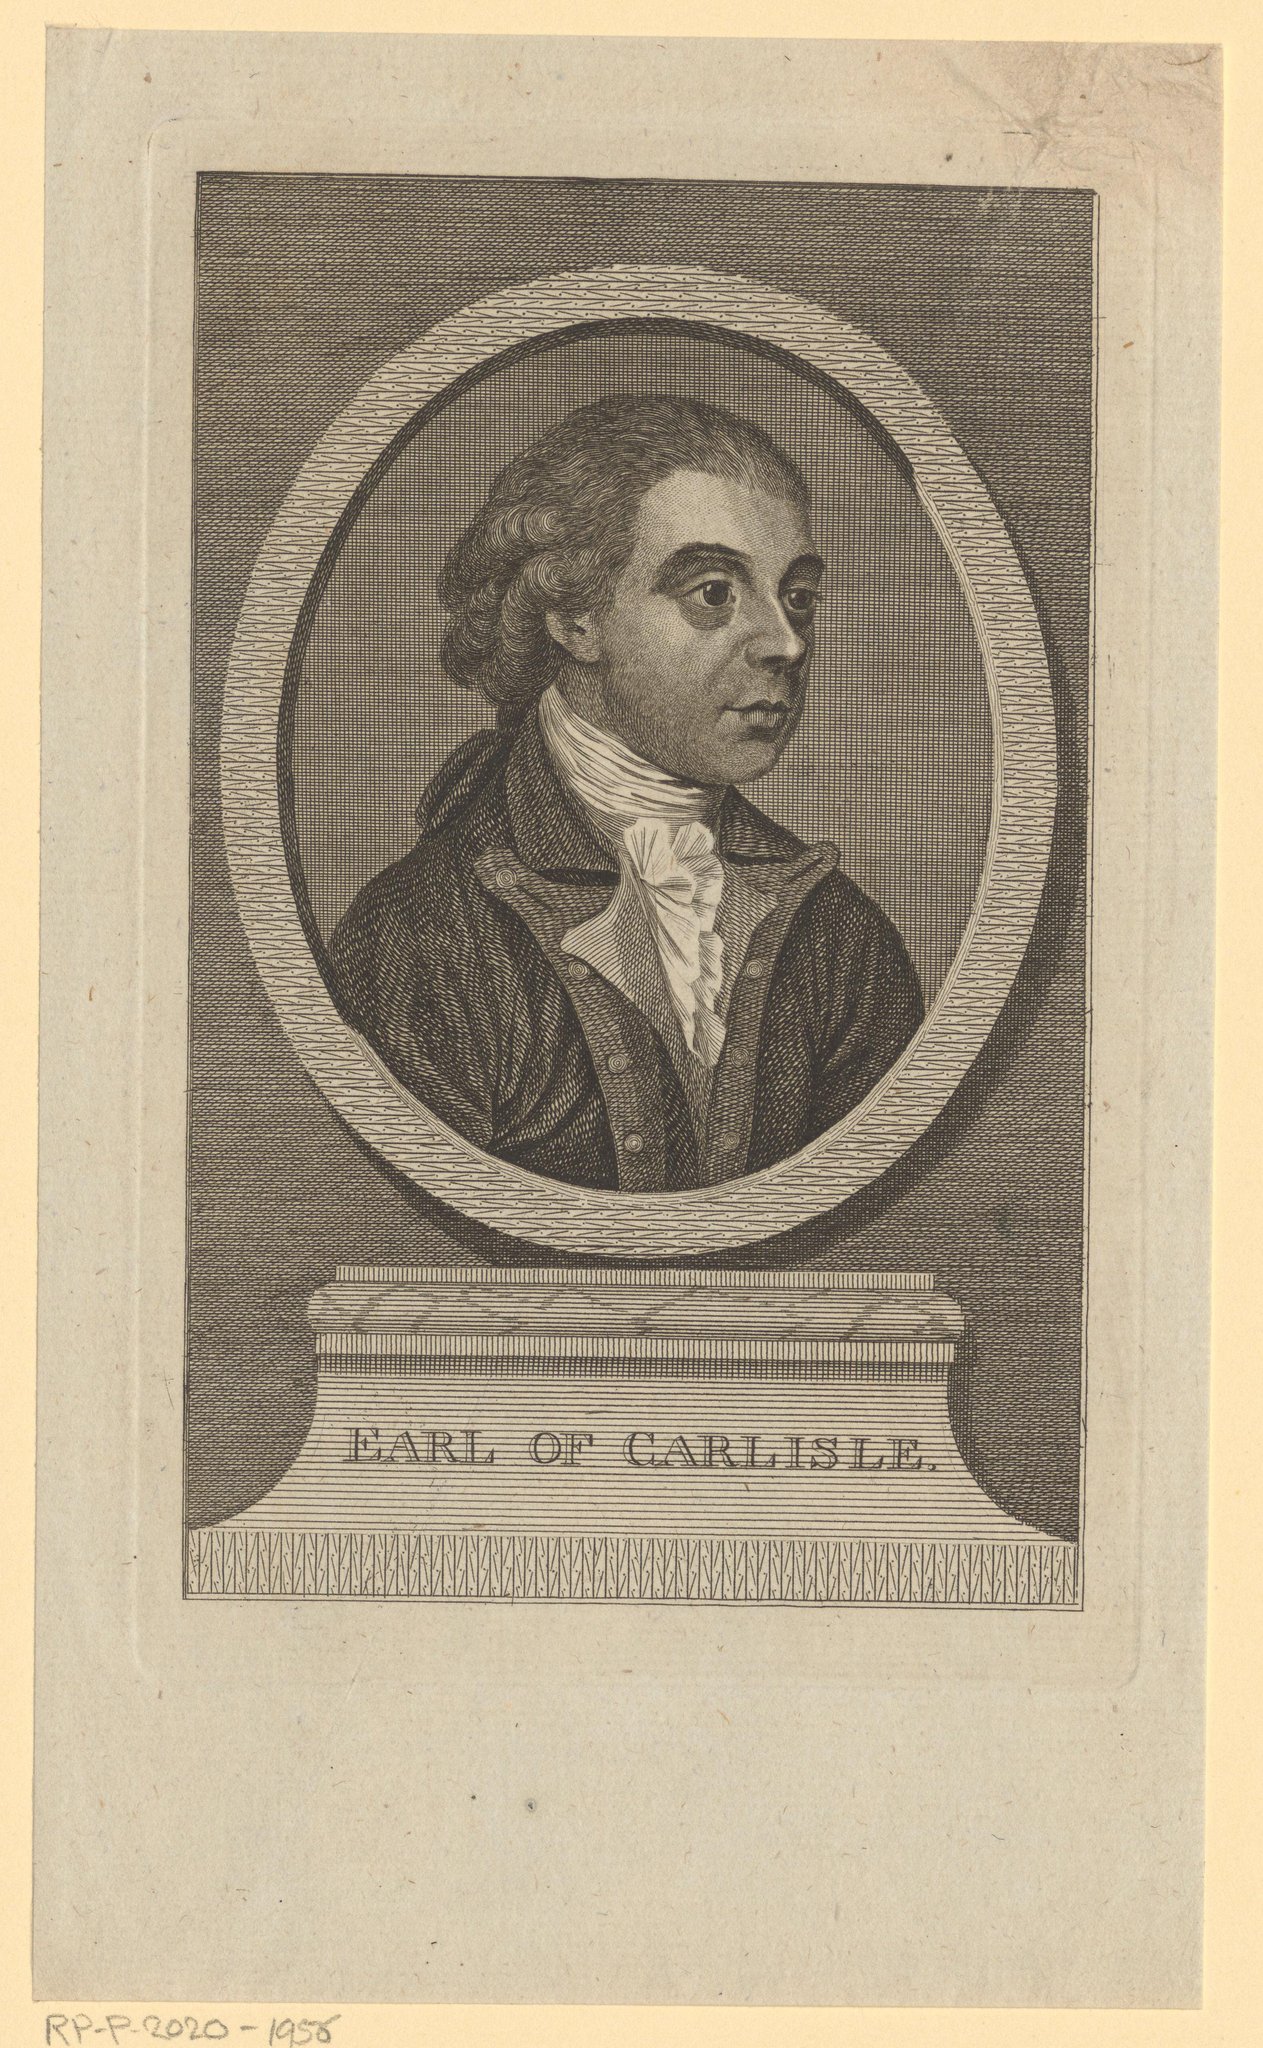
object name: print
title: Portret van Frederick Howard, vijfde graaf van Carlisle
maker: Anonymous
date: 1768-1849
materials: paper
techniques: engraving, etching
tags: frederick howard (5e graaf van carlisle), historical persons